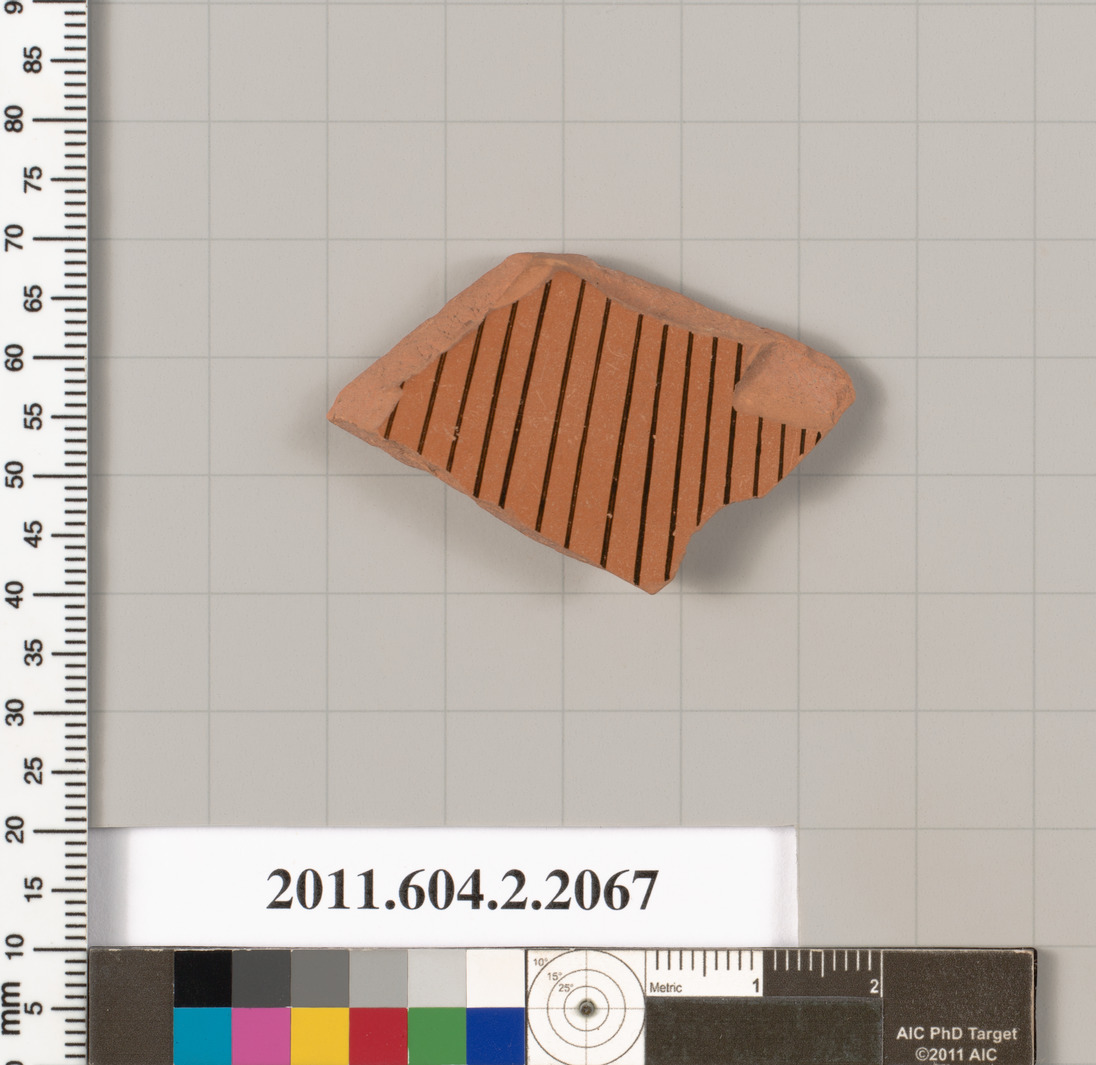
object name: pot fragment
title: Terracotta fragment of a pot; glazed on the inside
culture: greek, attic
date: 480-470 BCE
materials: terracotta